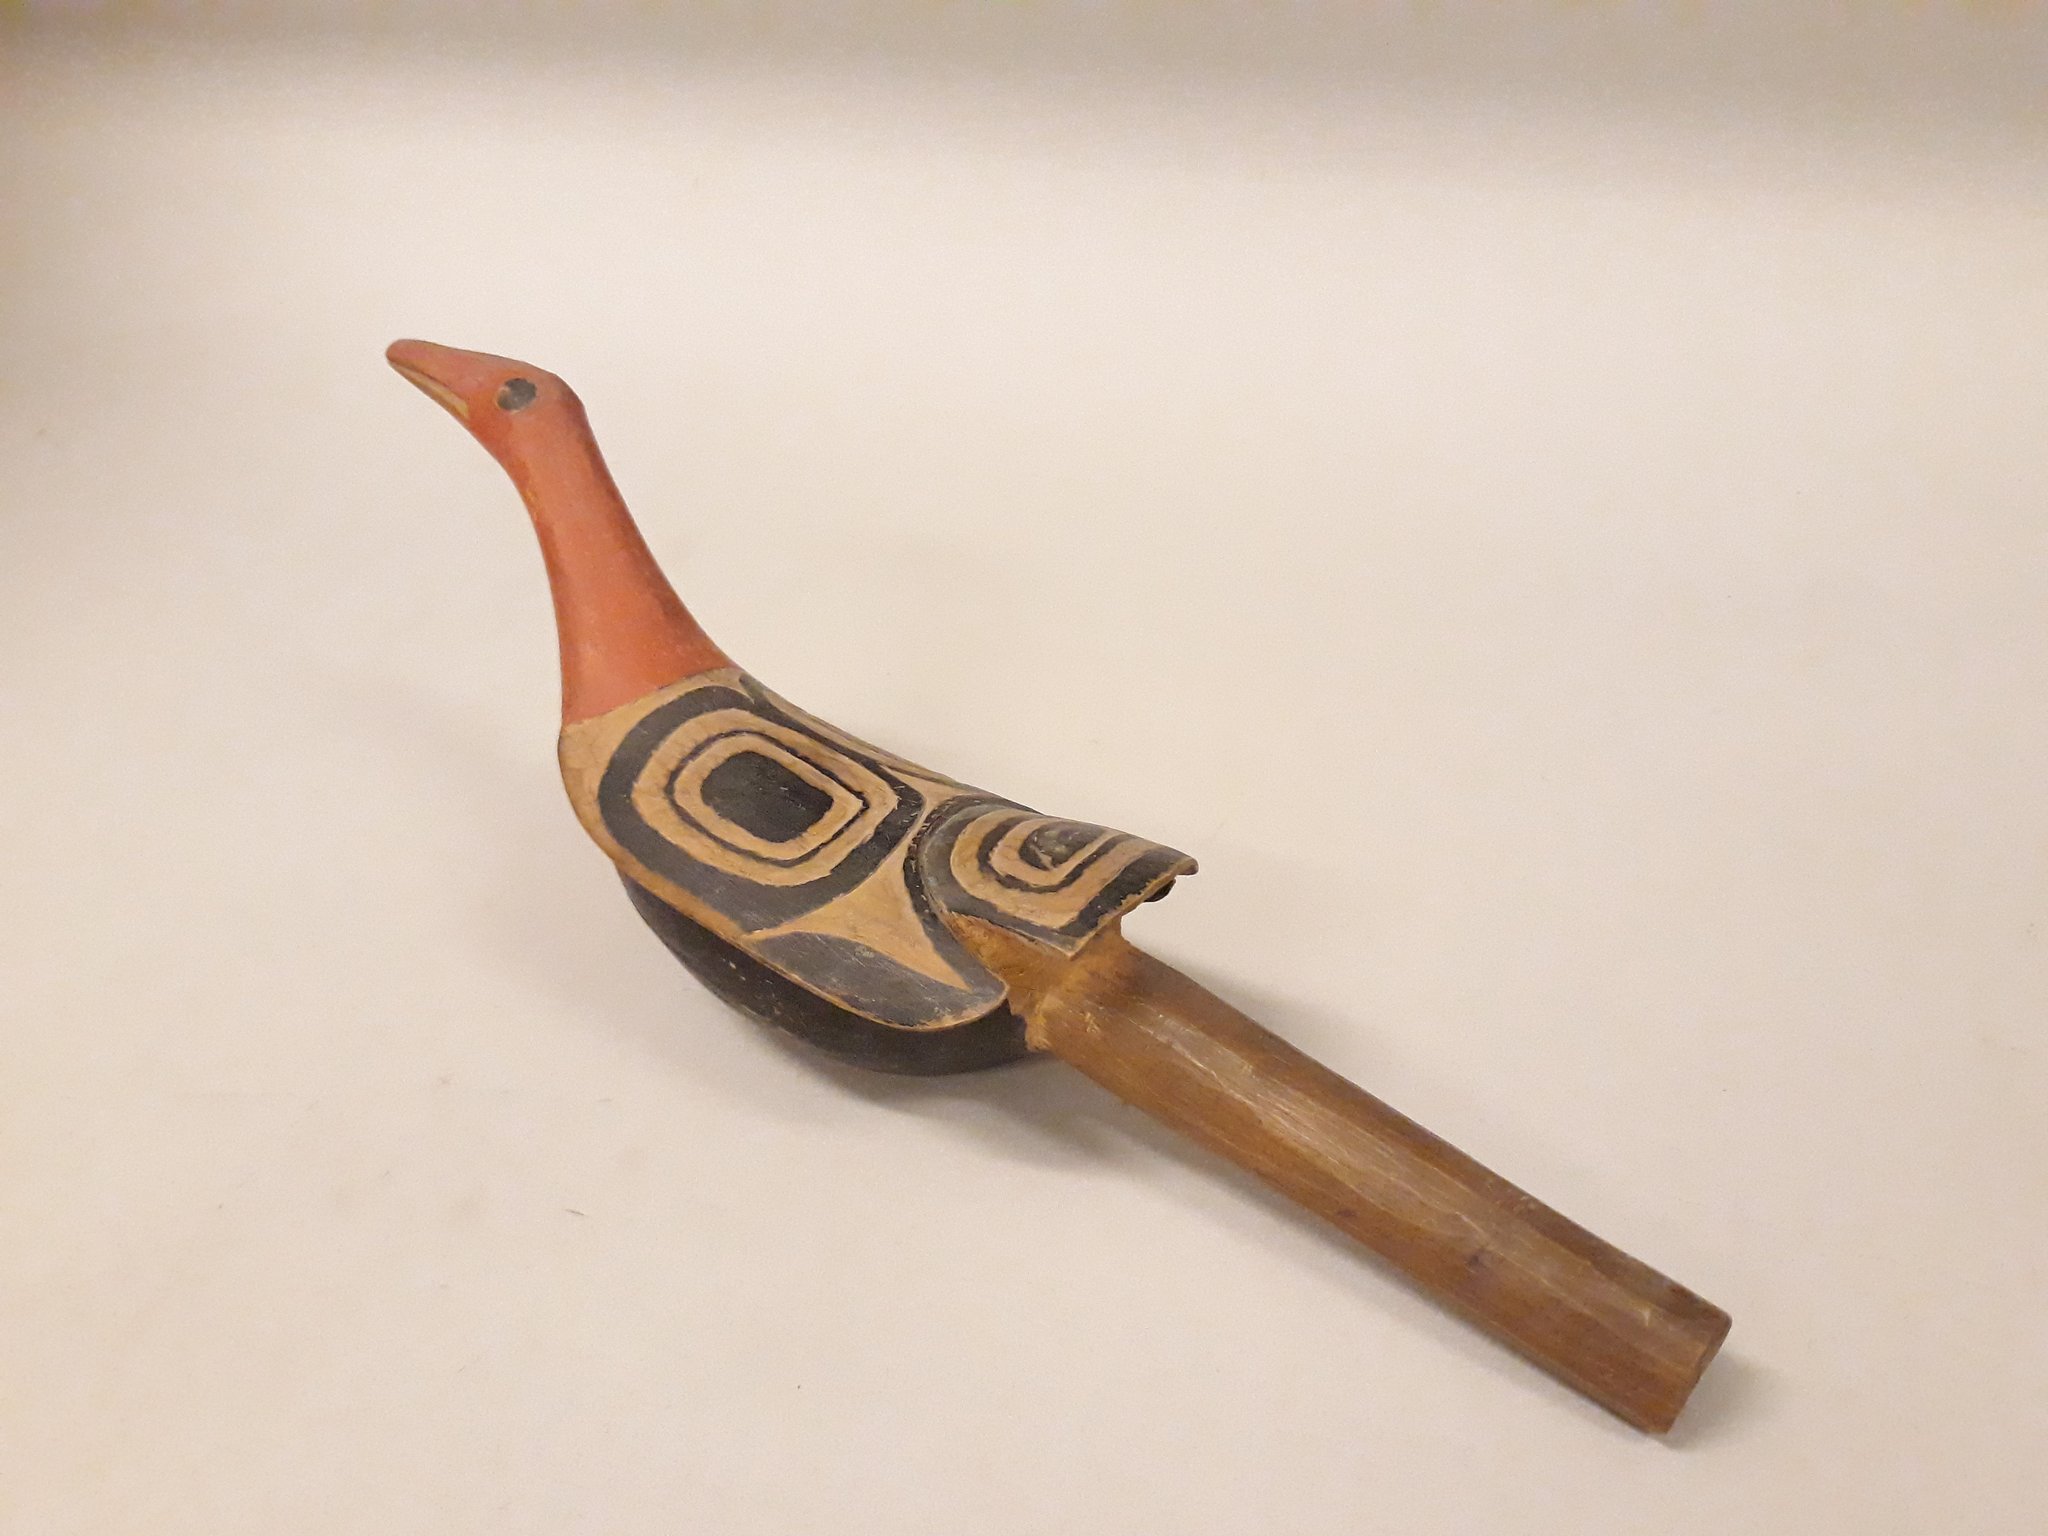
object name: rattle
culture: native american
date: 1801-1900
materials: wood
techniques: polychrome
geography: canada